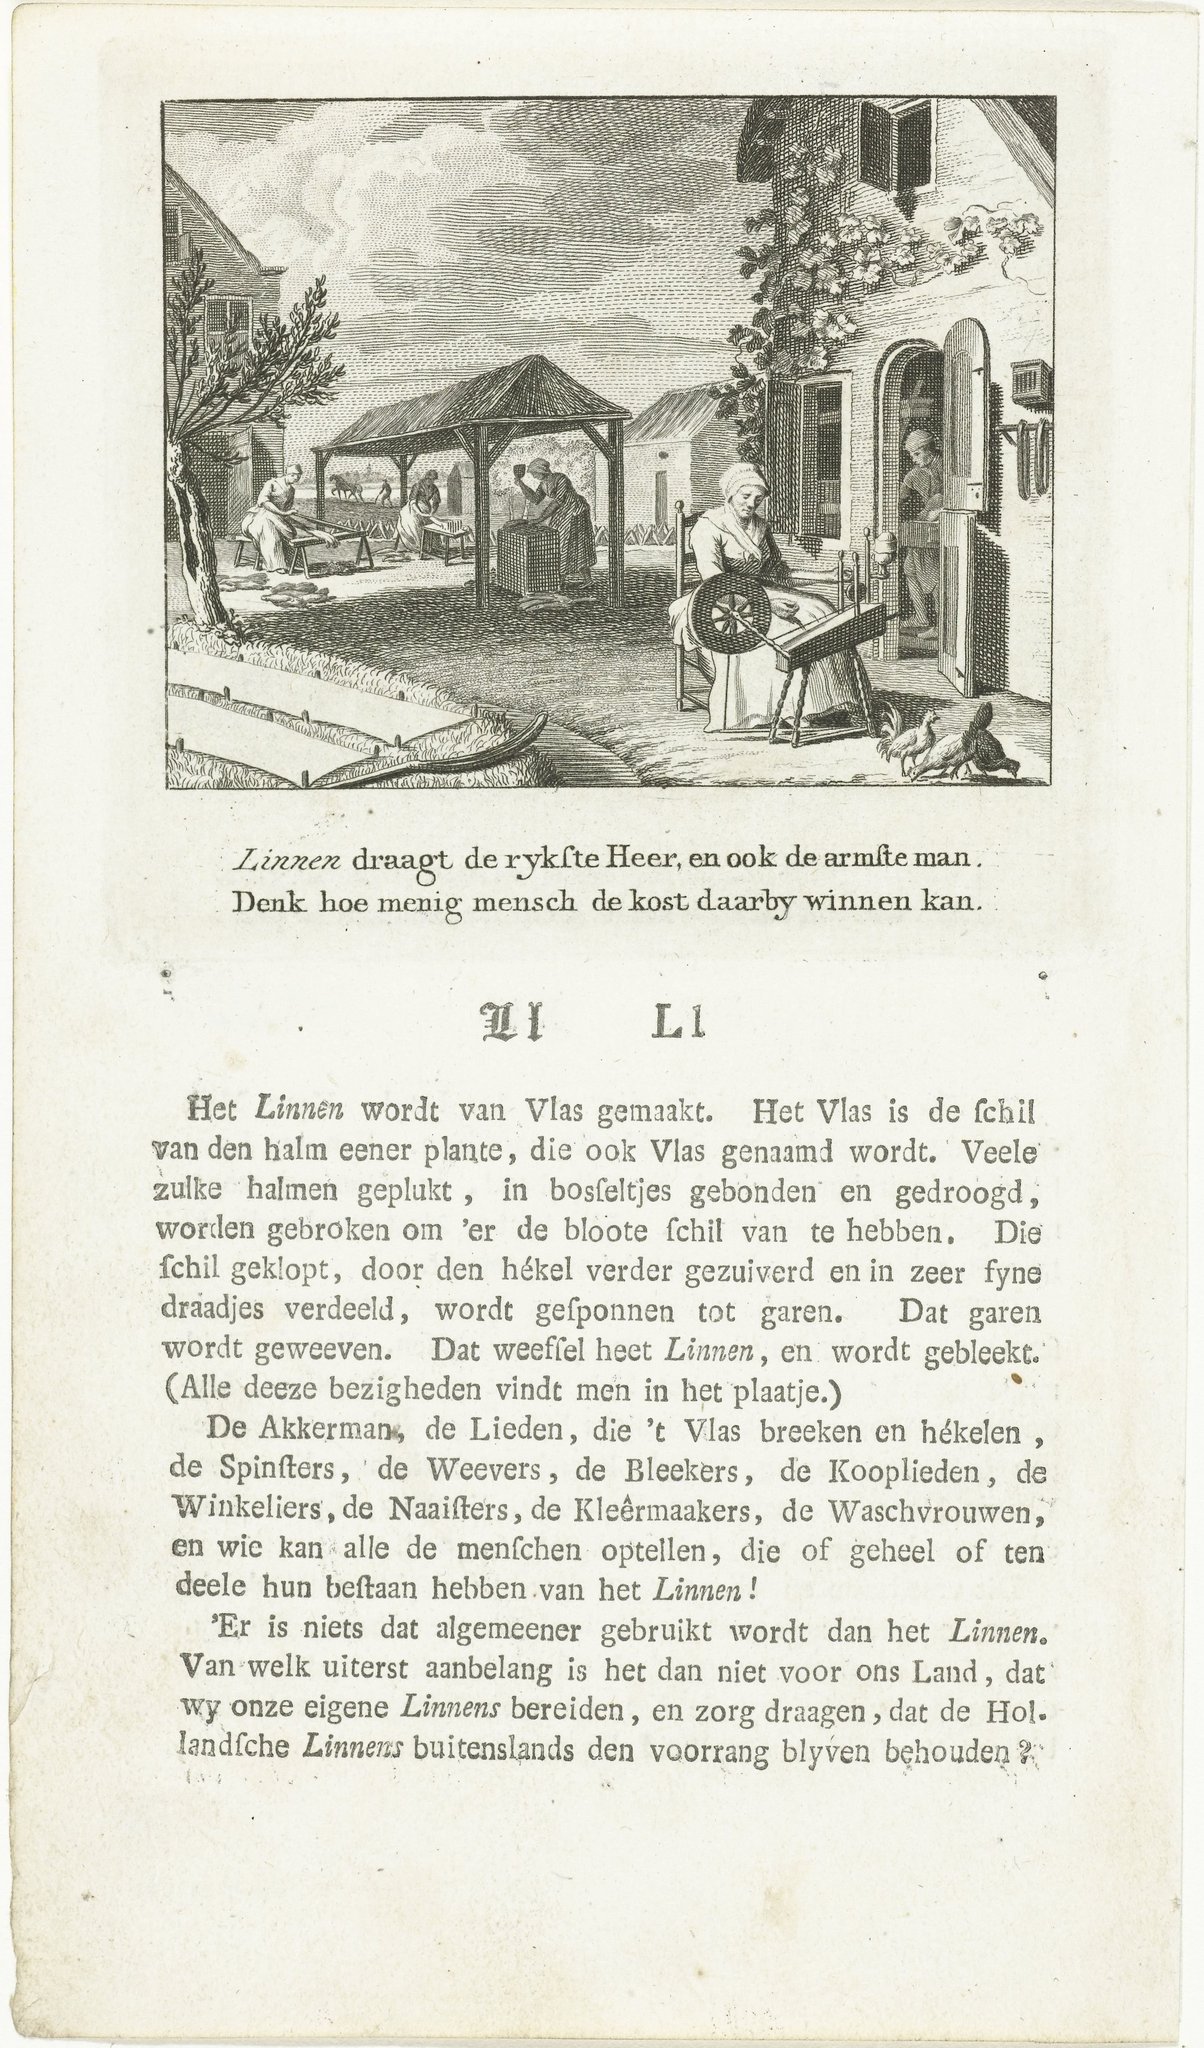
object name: book illustration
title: De productie van linnen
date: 1781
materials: paper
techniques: etching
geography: amsterdam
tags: spinning-wheel, laying the wash out to dry, fashion, clothing (+ materials used for clothes)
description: Illustratie voor de letter L in het 'Vaderlandsch A-B boek, voor de Nederlandsche jeugd' door J.H. Swilden. Vrouwen zijn in de buitenlucht bezig met de productie van linnen. Onder een afdak zijn drie vrouwen bezig met het voorbereiden van de grondstof. Op de voorgrond is een vrouw aan het spinnen. Op het gras liggen linnen doeken te drogen. Onder de afbeelding een tweeregelig versje. Onder de letter een beschrijving van het begrip.